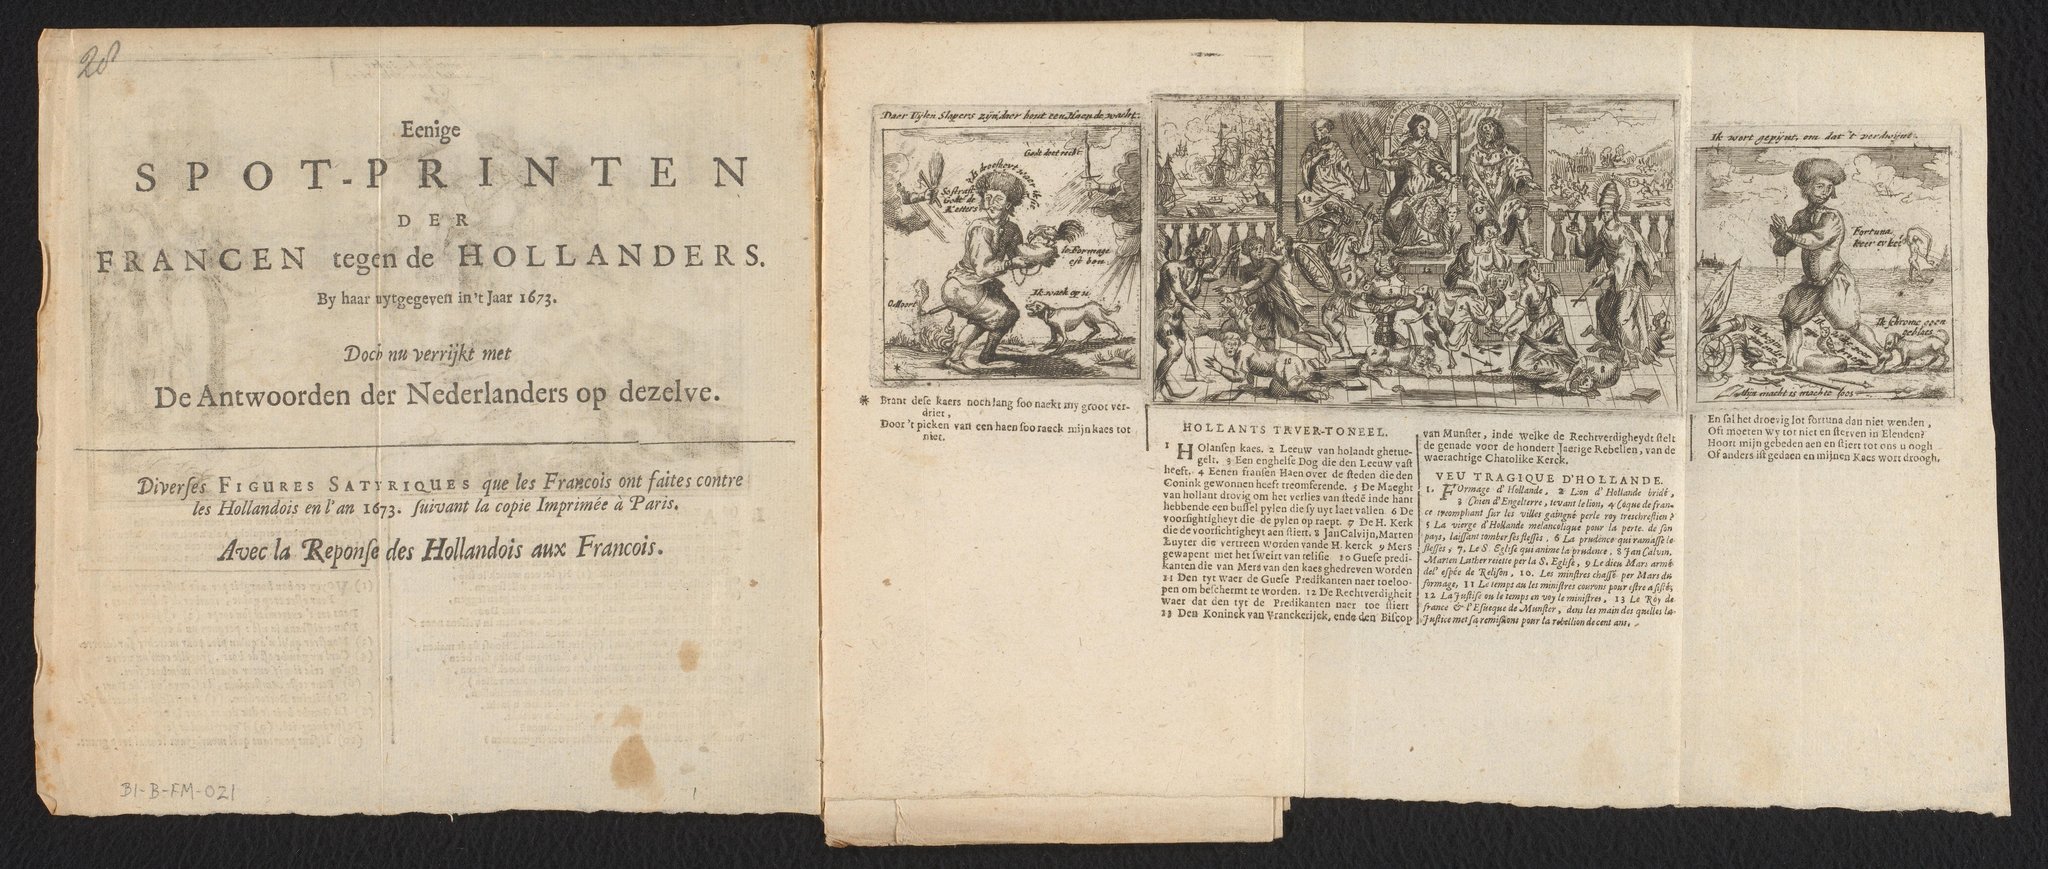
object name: cartoon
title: Hollants truer-toneel / Veu tragique d'Hollande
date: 1673-1674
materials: paper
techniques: etching, letterpress printing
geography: northern netherlands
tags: lodewijk xiv (koning van frankrijk), vomiting, political caricatures and satires, rampjaar (disaster year)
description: Hollands treurtoneel, 1673. Kopie nr. II naar de Franse spotprent met drie voorstellingen over de aanval op de Republiek door de Franse en Bischoppelijke legers in 1672. In de centrale voorstelling zit de Rechtvaardigheid op troon tussen Lodewijk XIV en de bisschop van Munster ziet toe hoe de Franse haan de Hollandse kaas opeet terwijl de Hollandse Leeuw geboeid door een Engelse hond hulpeloos toeziet. De Hollandse Maagd zit verslagen in een stoel en heeft de pijlenbundel van de zeven verenigde provincies laten vallen. Rechts vertreedt de katolieke kerk Calvijn en Luther, links proberen de geuzenpredikanten te vluchten. Aan weerszijden twee kleinere prenten. Links de Hollandse Matroos met een kaas in de handen en een kaars in zijn achterste. Rechts wordt de Hollandse Matroos gebeten door de Engelse hond en Franse Haan. Met de oorspronkelijke onderschriften in het Nederlands en Frans.